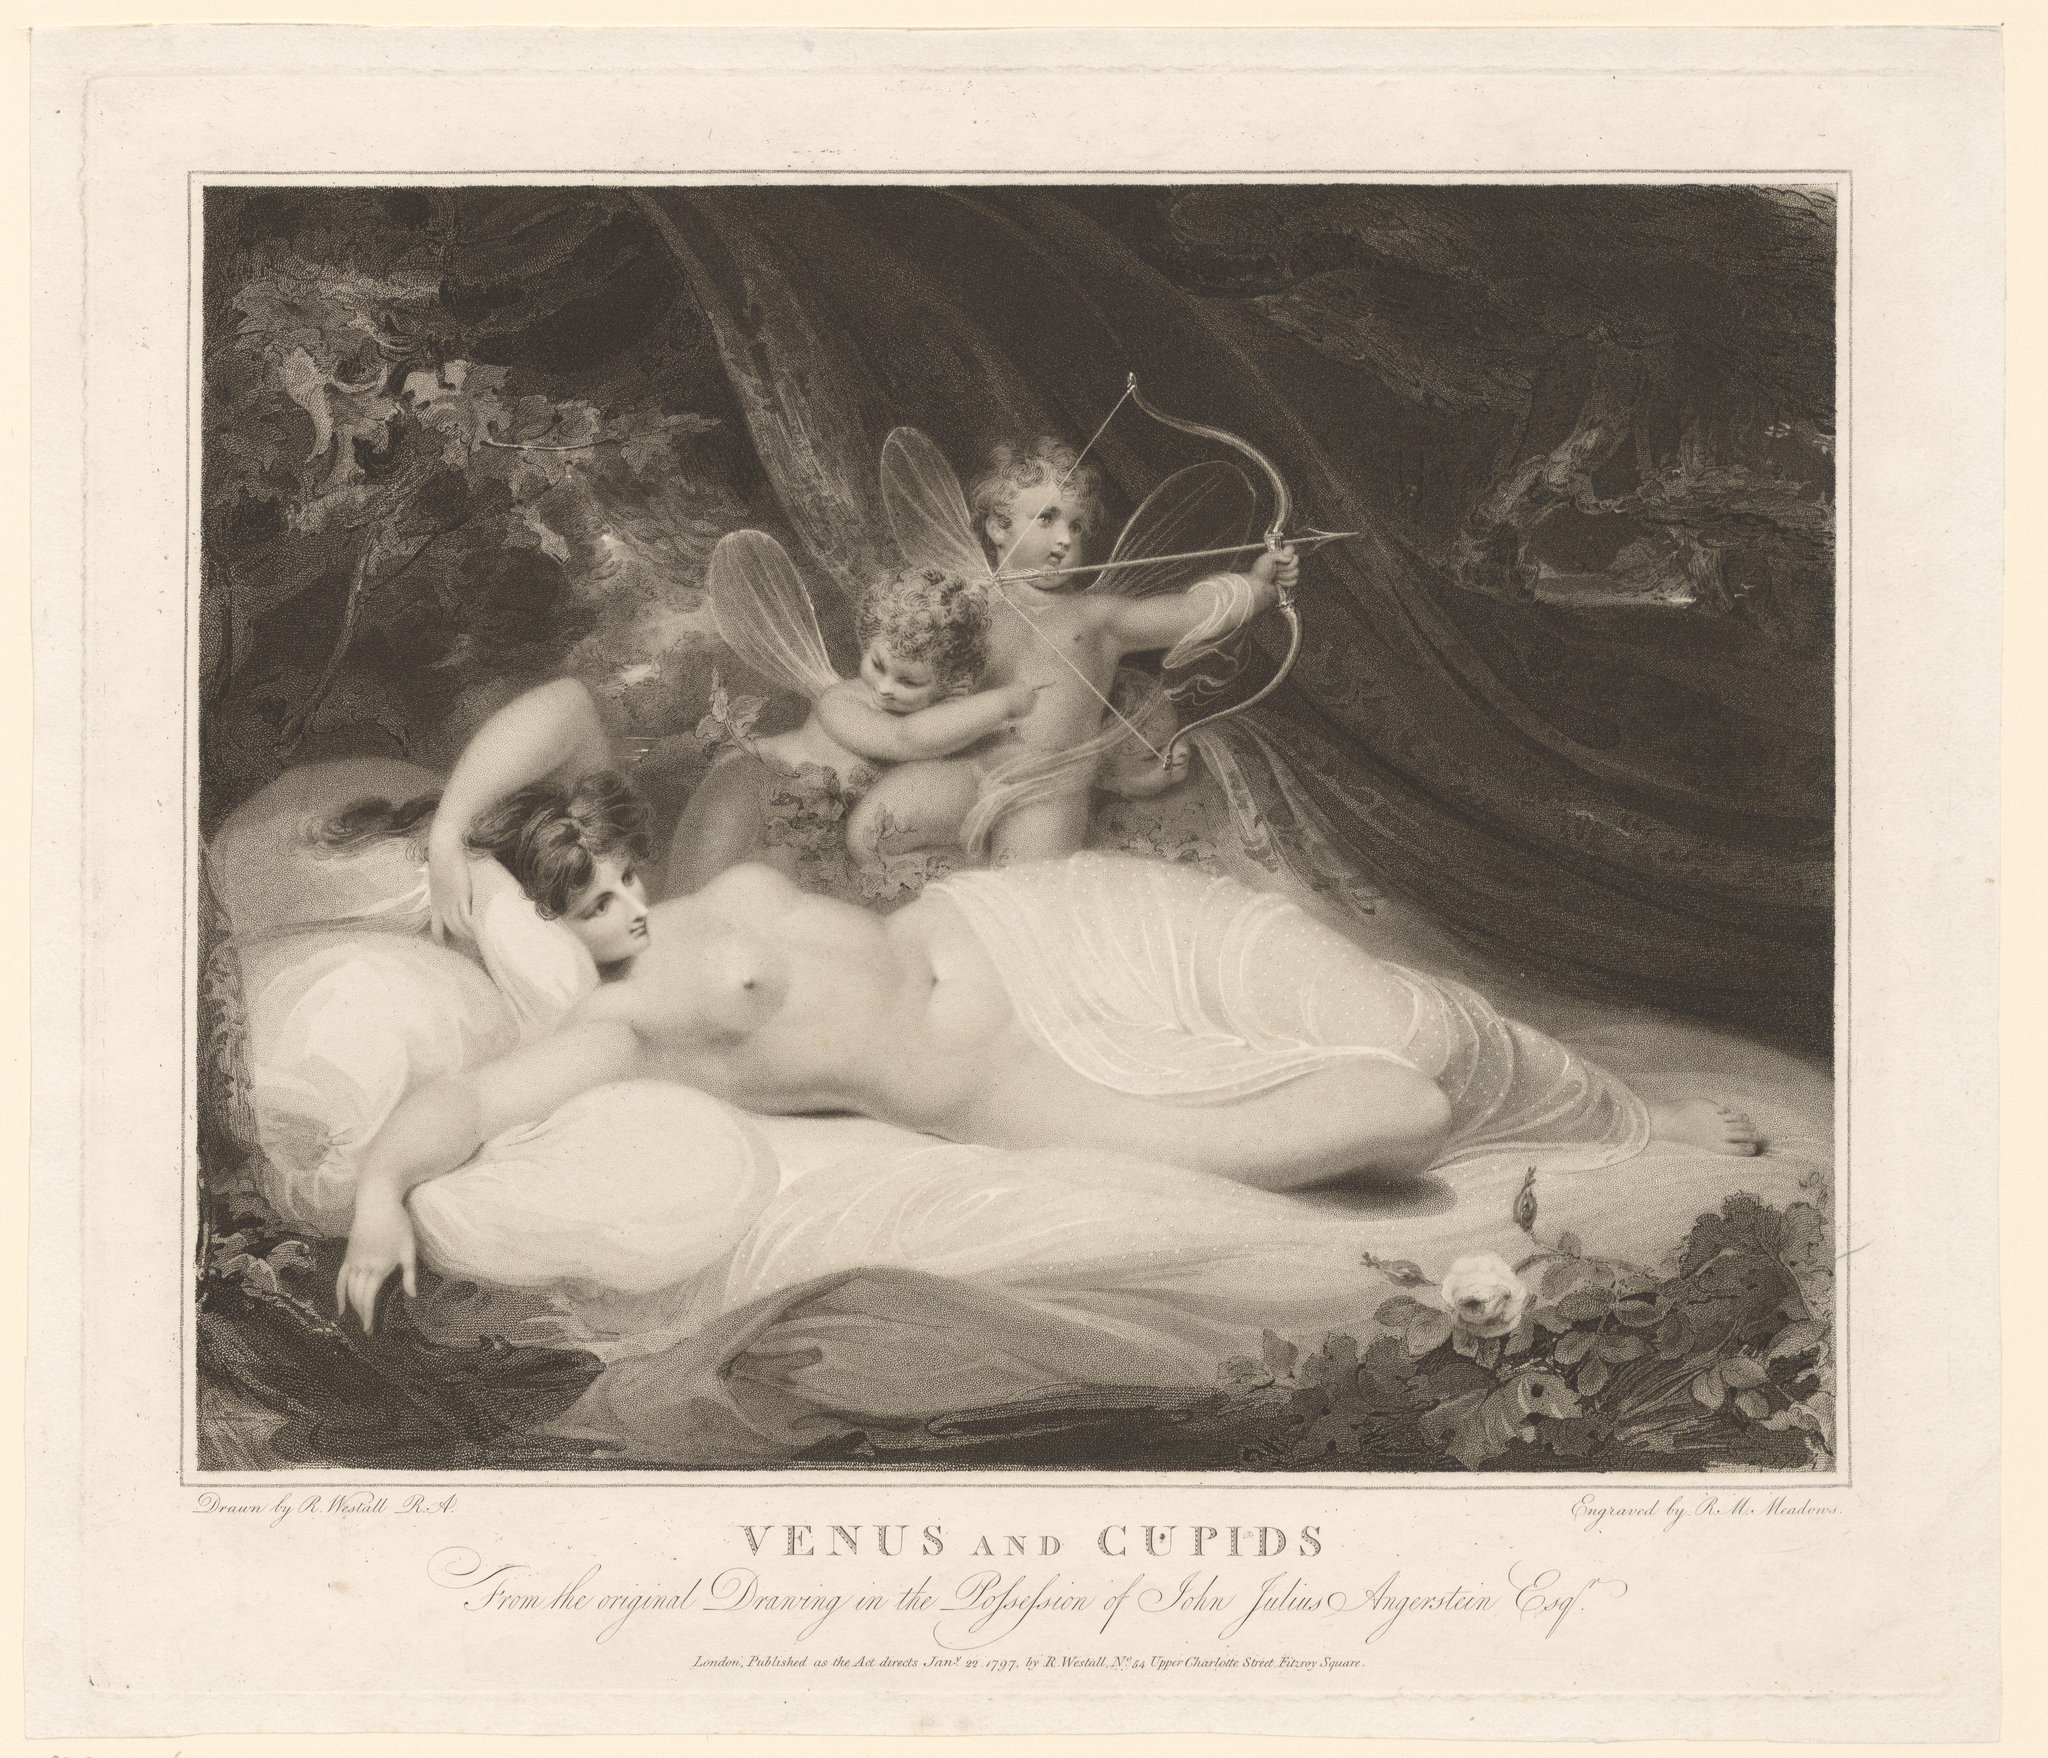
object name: print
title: Venus and Cupids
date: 1794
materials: paper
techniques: stippling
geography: london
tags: lying on one side, stretched out - aa - female human figure, attributes of cupid: bow and arrow, venus and cupid (cupid not being mere attribute)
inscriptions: collector's mark: Lugt 2228, collector's mark: Lugt 2760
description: Op de prent staat de datering 1794. Deze datering kan verwijzen naar de tekening van Westall of naar het maken van de plaat door Meadows. De prent is uitgegeven in 1797 door Westall.